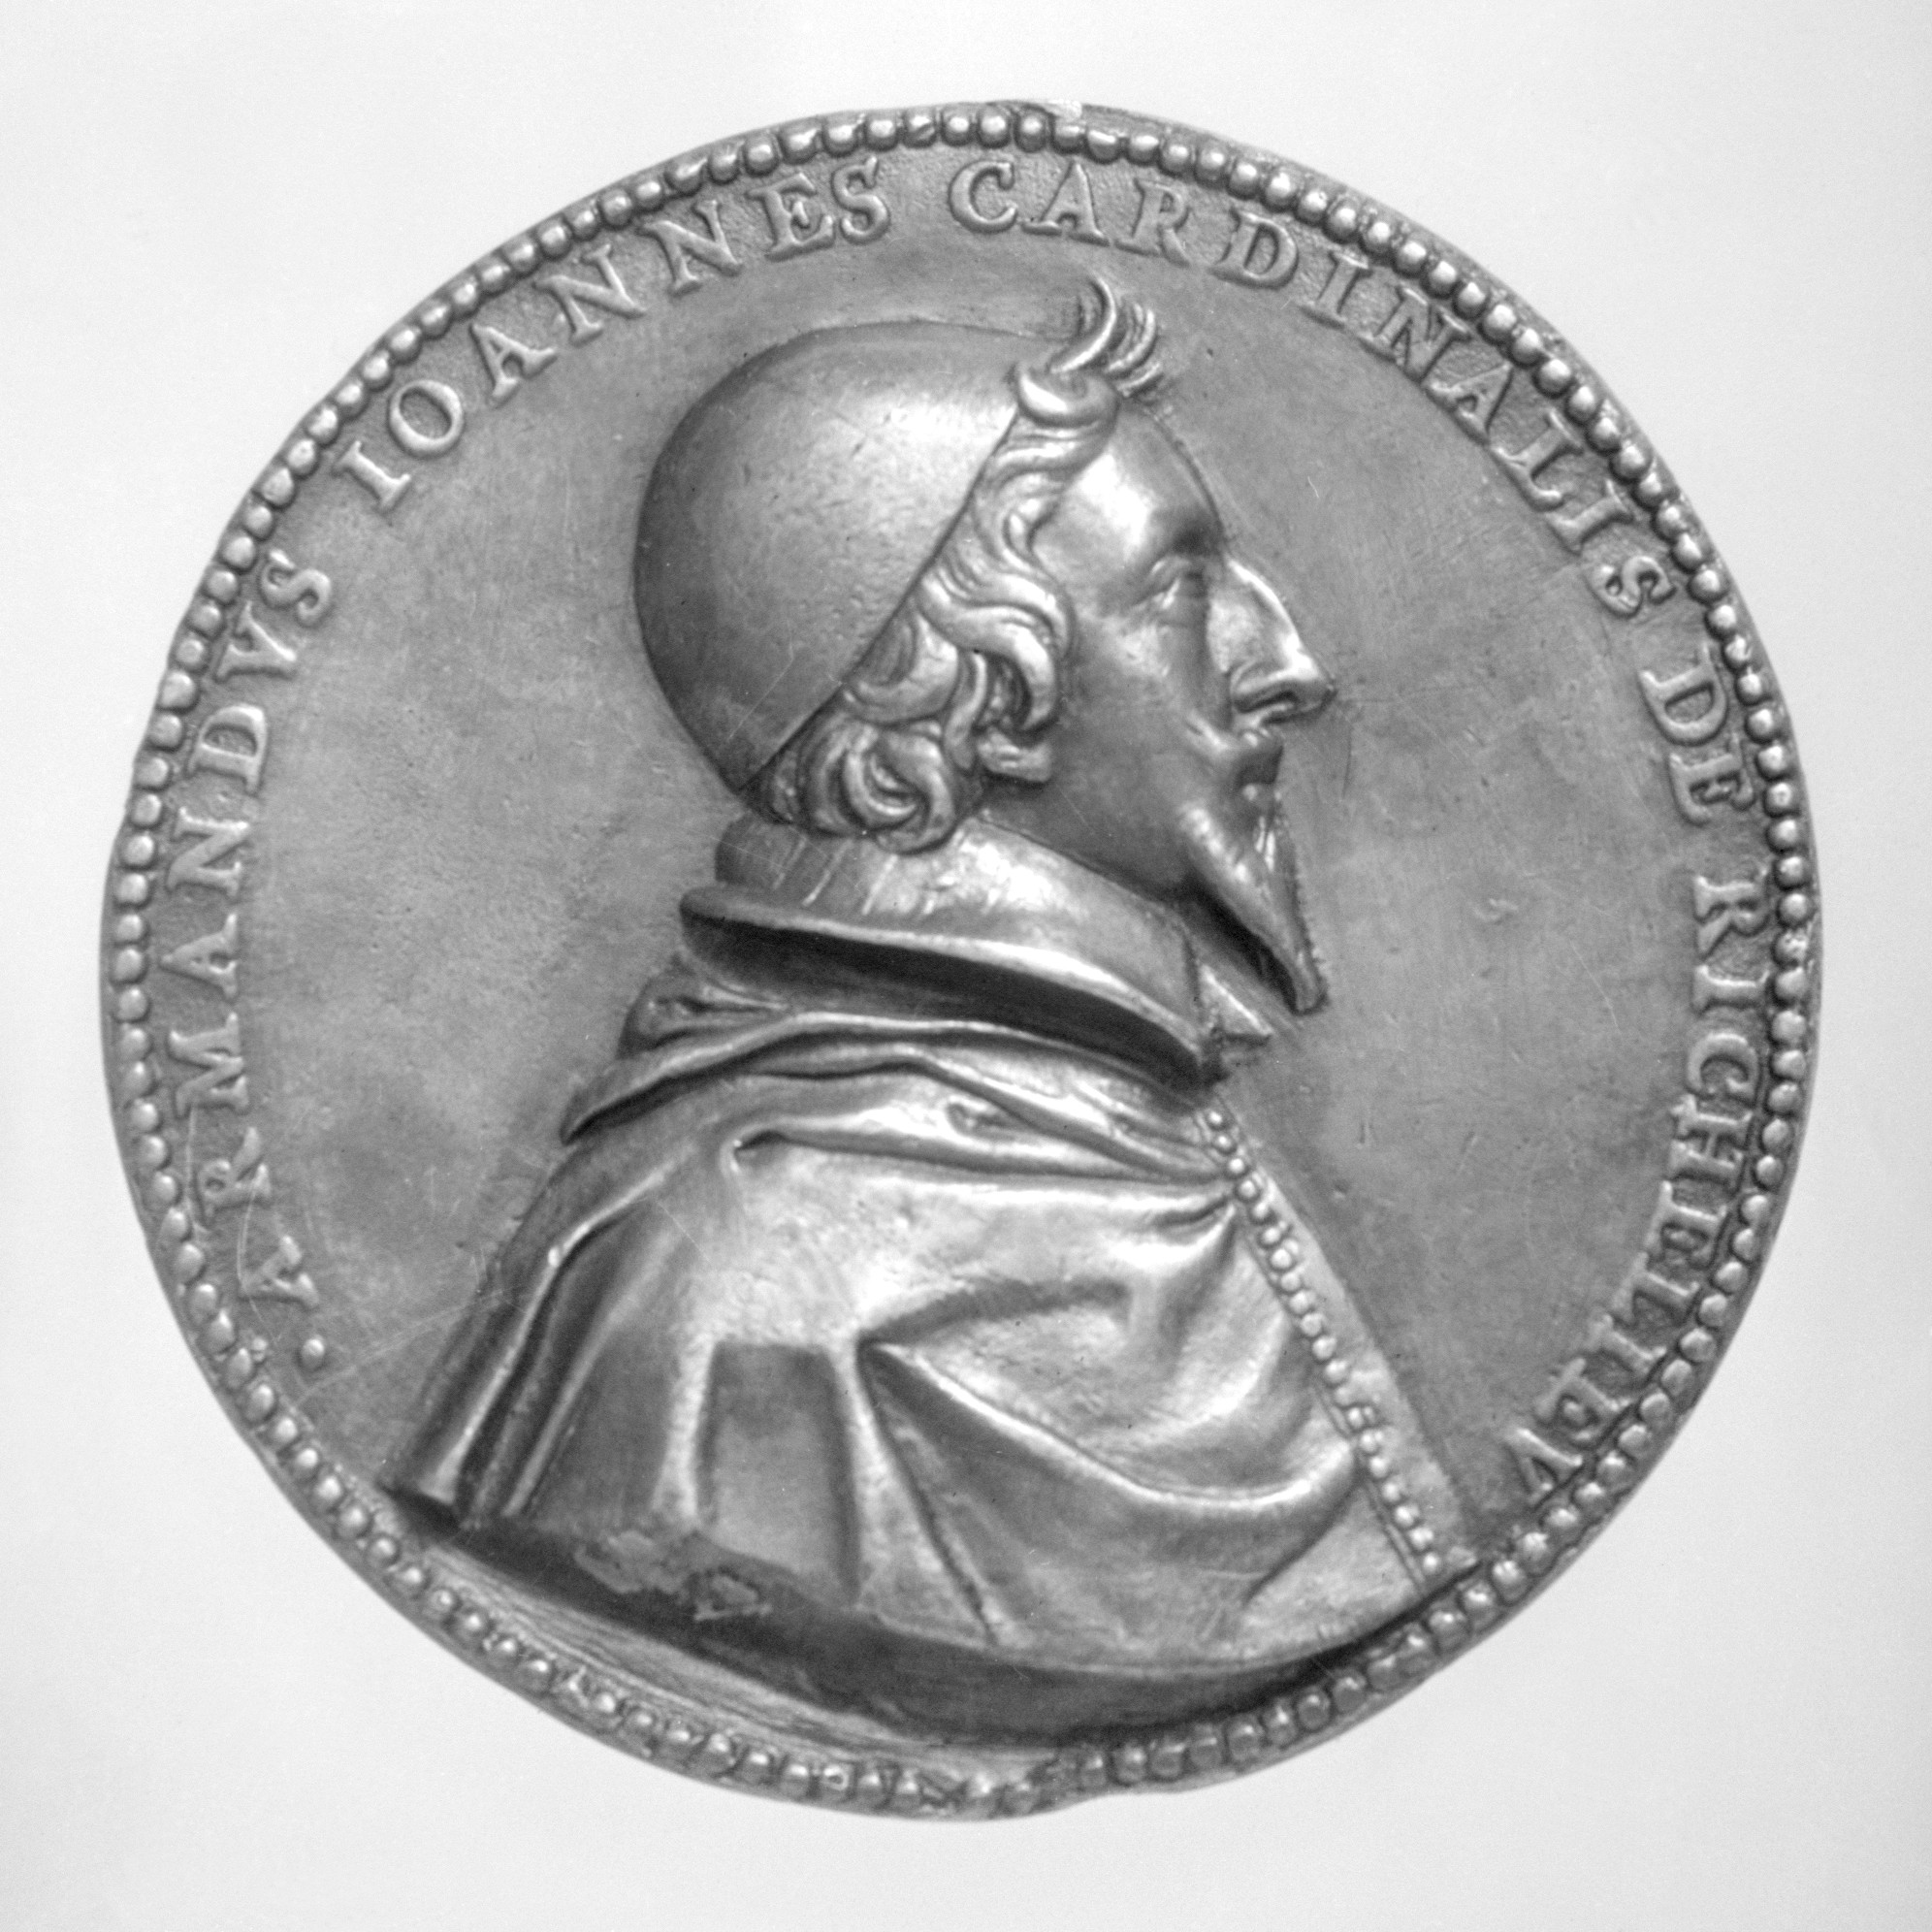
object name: medal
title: Armand-Jean Duplessis, Cardinal Richelieu (1585–1642)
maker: jean varin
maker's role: artist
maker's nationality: french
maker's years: 1606-1672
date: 1630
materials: bronze, patina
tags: men,profiles,horses,chariots